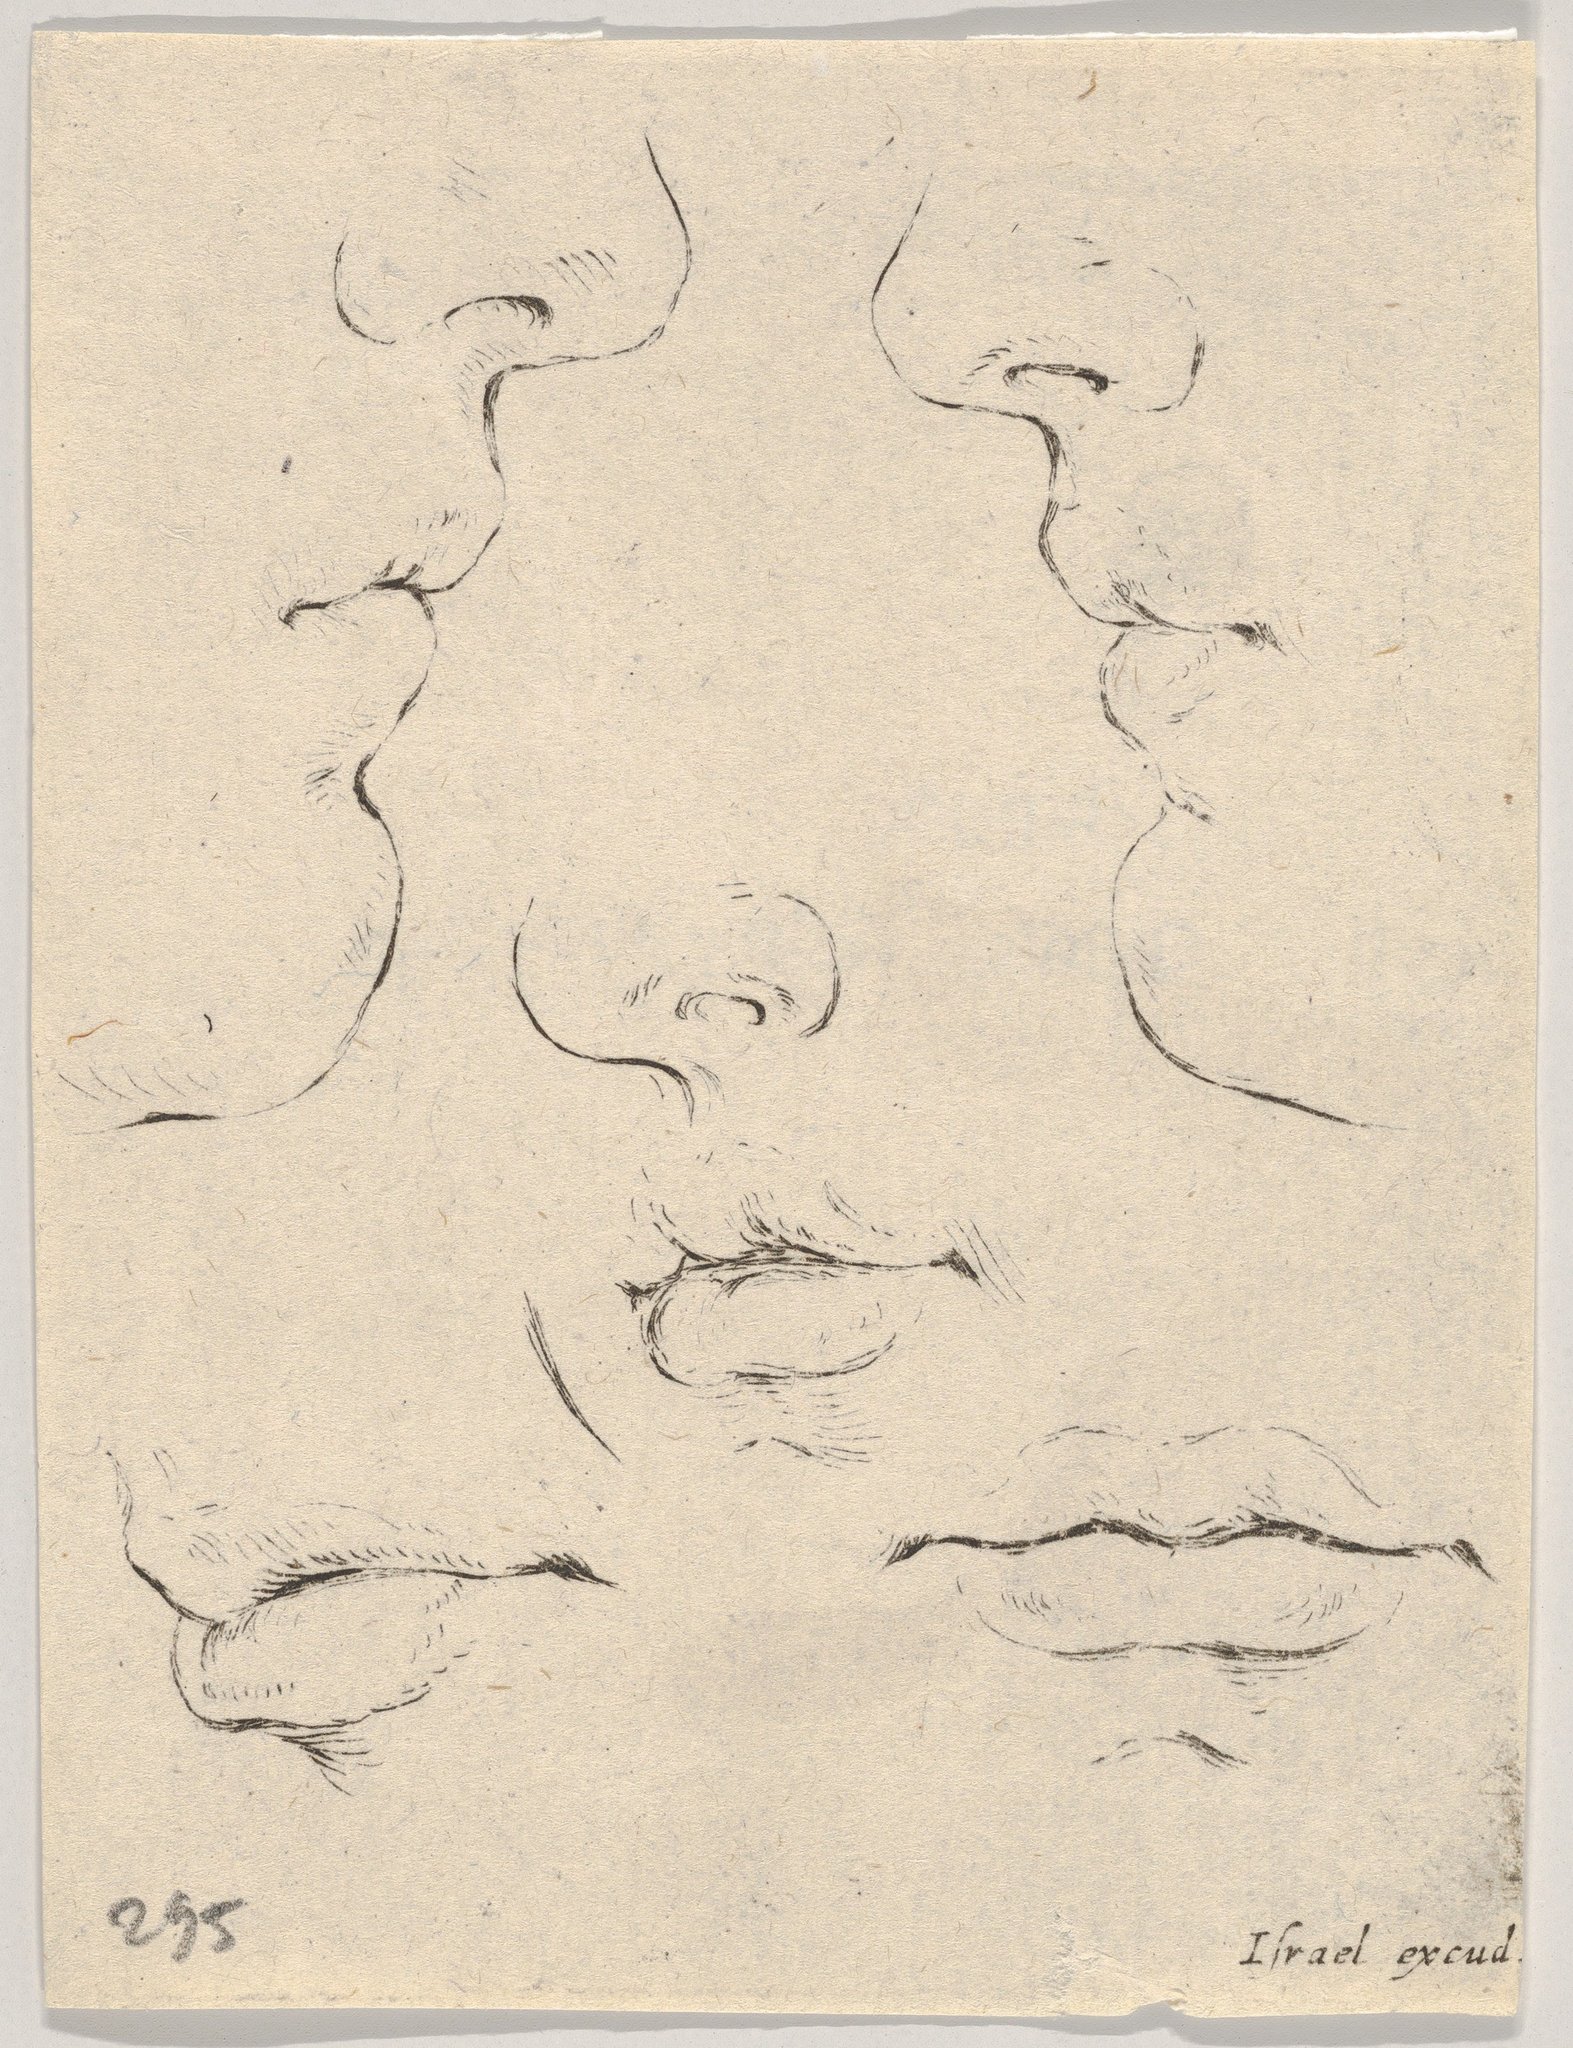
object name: print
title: Plate 4: Two profiles and three mouths, from "The Book for Learning to Draw" (Livre pour apprendre à dessiner)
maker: stefano della bella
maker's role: artist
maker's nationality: italian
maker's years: 1610-1664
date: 1649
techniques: etching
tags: mouths,profiles